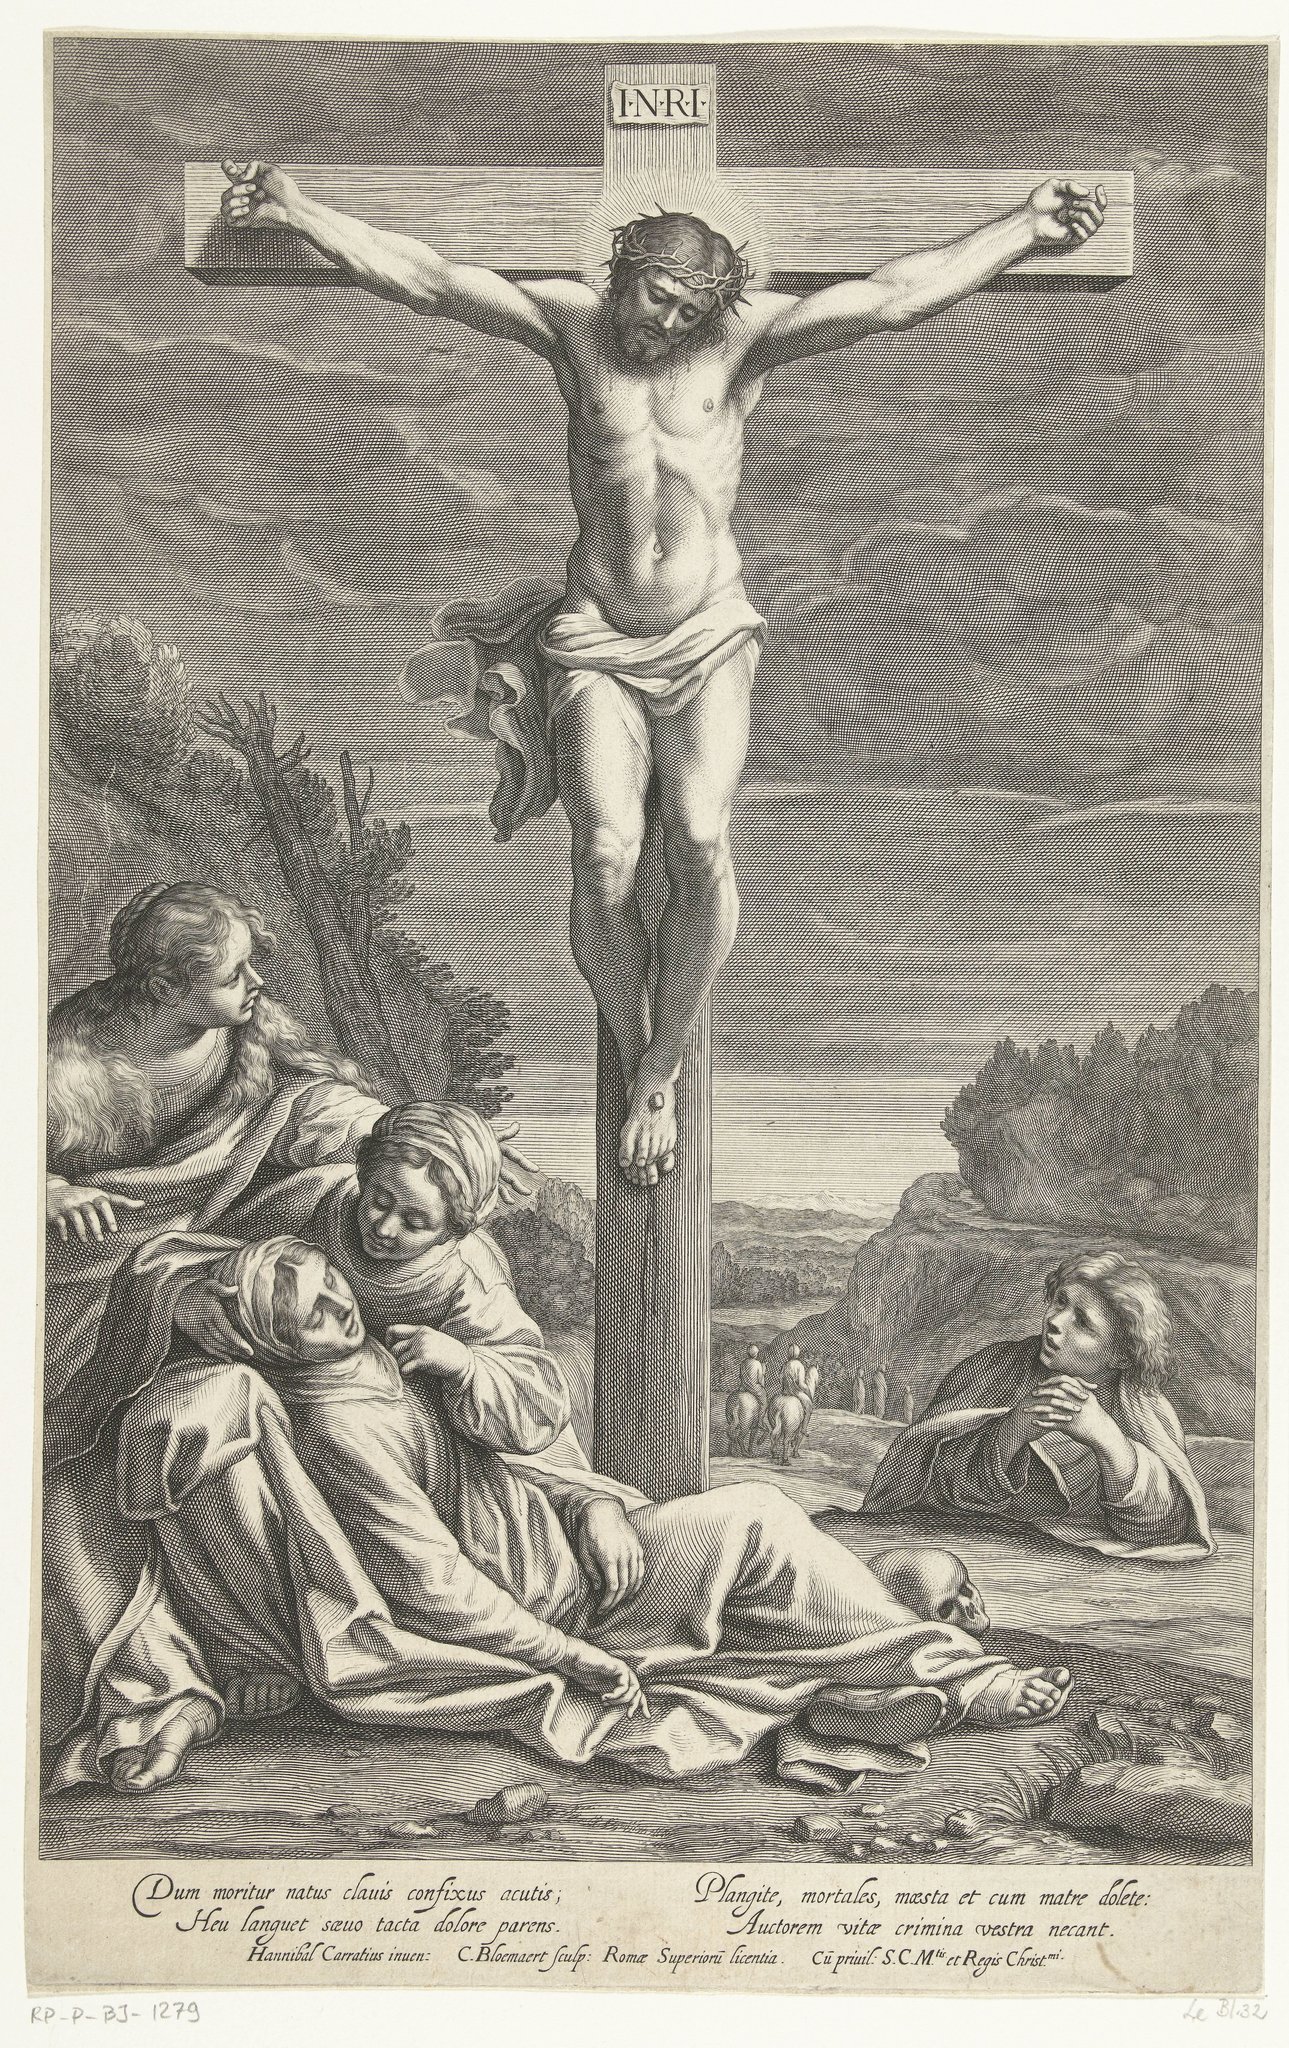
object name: print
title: Kruisiging van Christus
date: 1633-1692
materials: paper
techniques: engraving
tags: the crucifixion of christ: christ's death on the cross; golgotha (matthew 27:45-58; mark 15:33-45; luke 23:44-52; john 19:25-38)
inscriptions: collector's mark: Lugt 2228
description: Christus aan het kruis genageld. Maria ligt bezwijmd aan de voet van het kruis, ondersteund door de heilige vrouwen. Johannes de Doper is rechts van het kruis afgebeeld. De doodskop aan de voet van het kruis duidt niet alleen Golgotha aan, de Schedelplaats, maar stelt tevens Adams schedel voor.